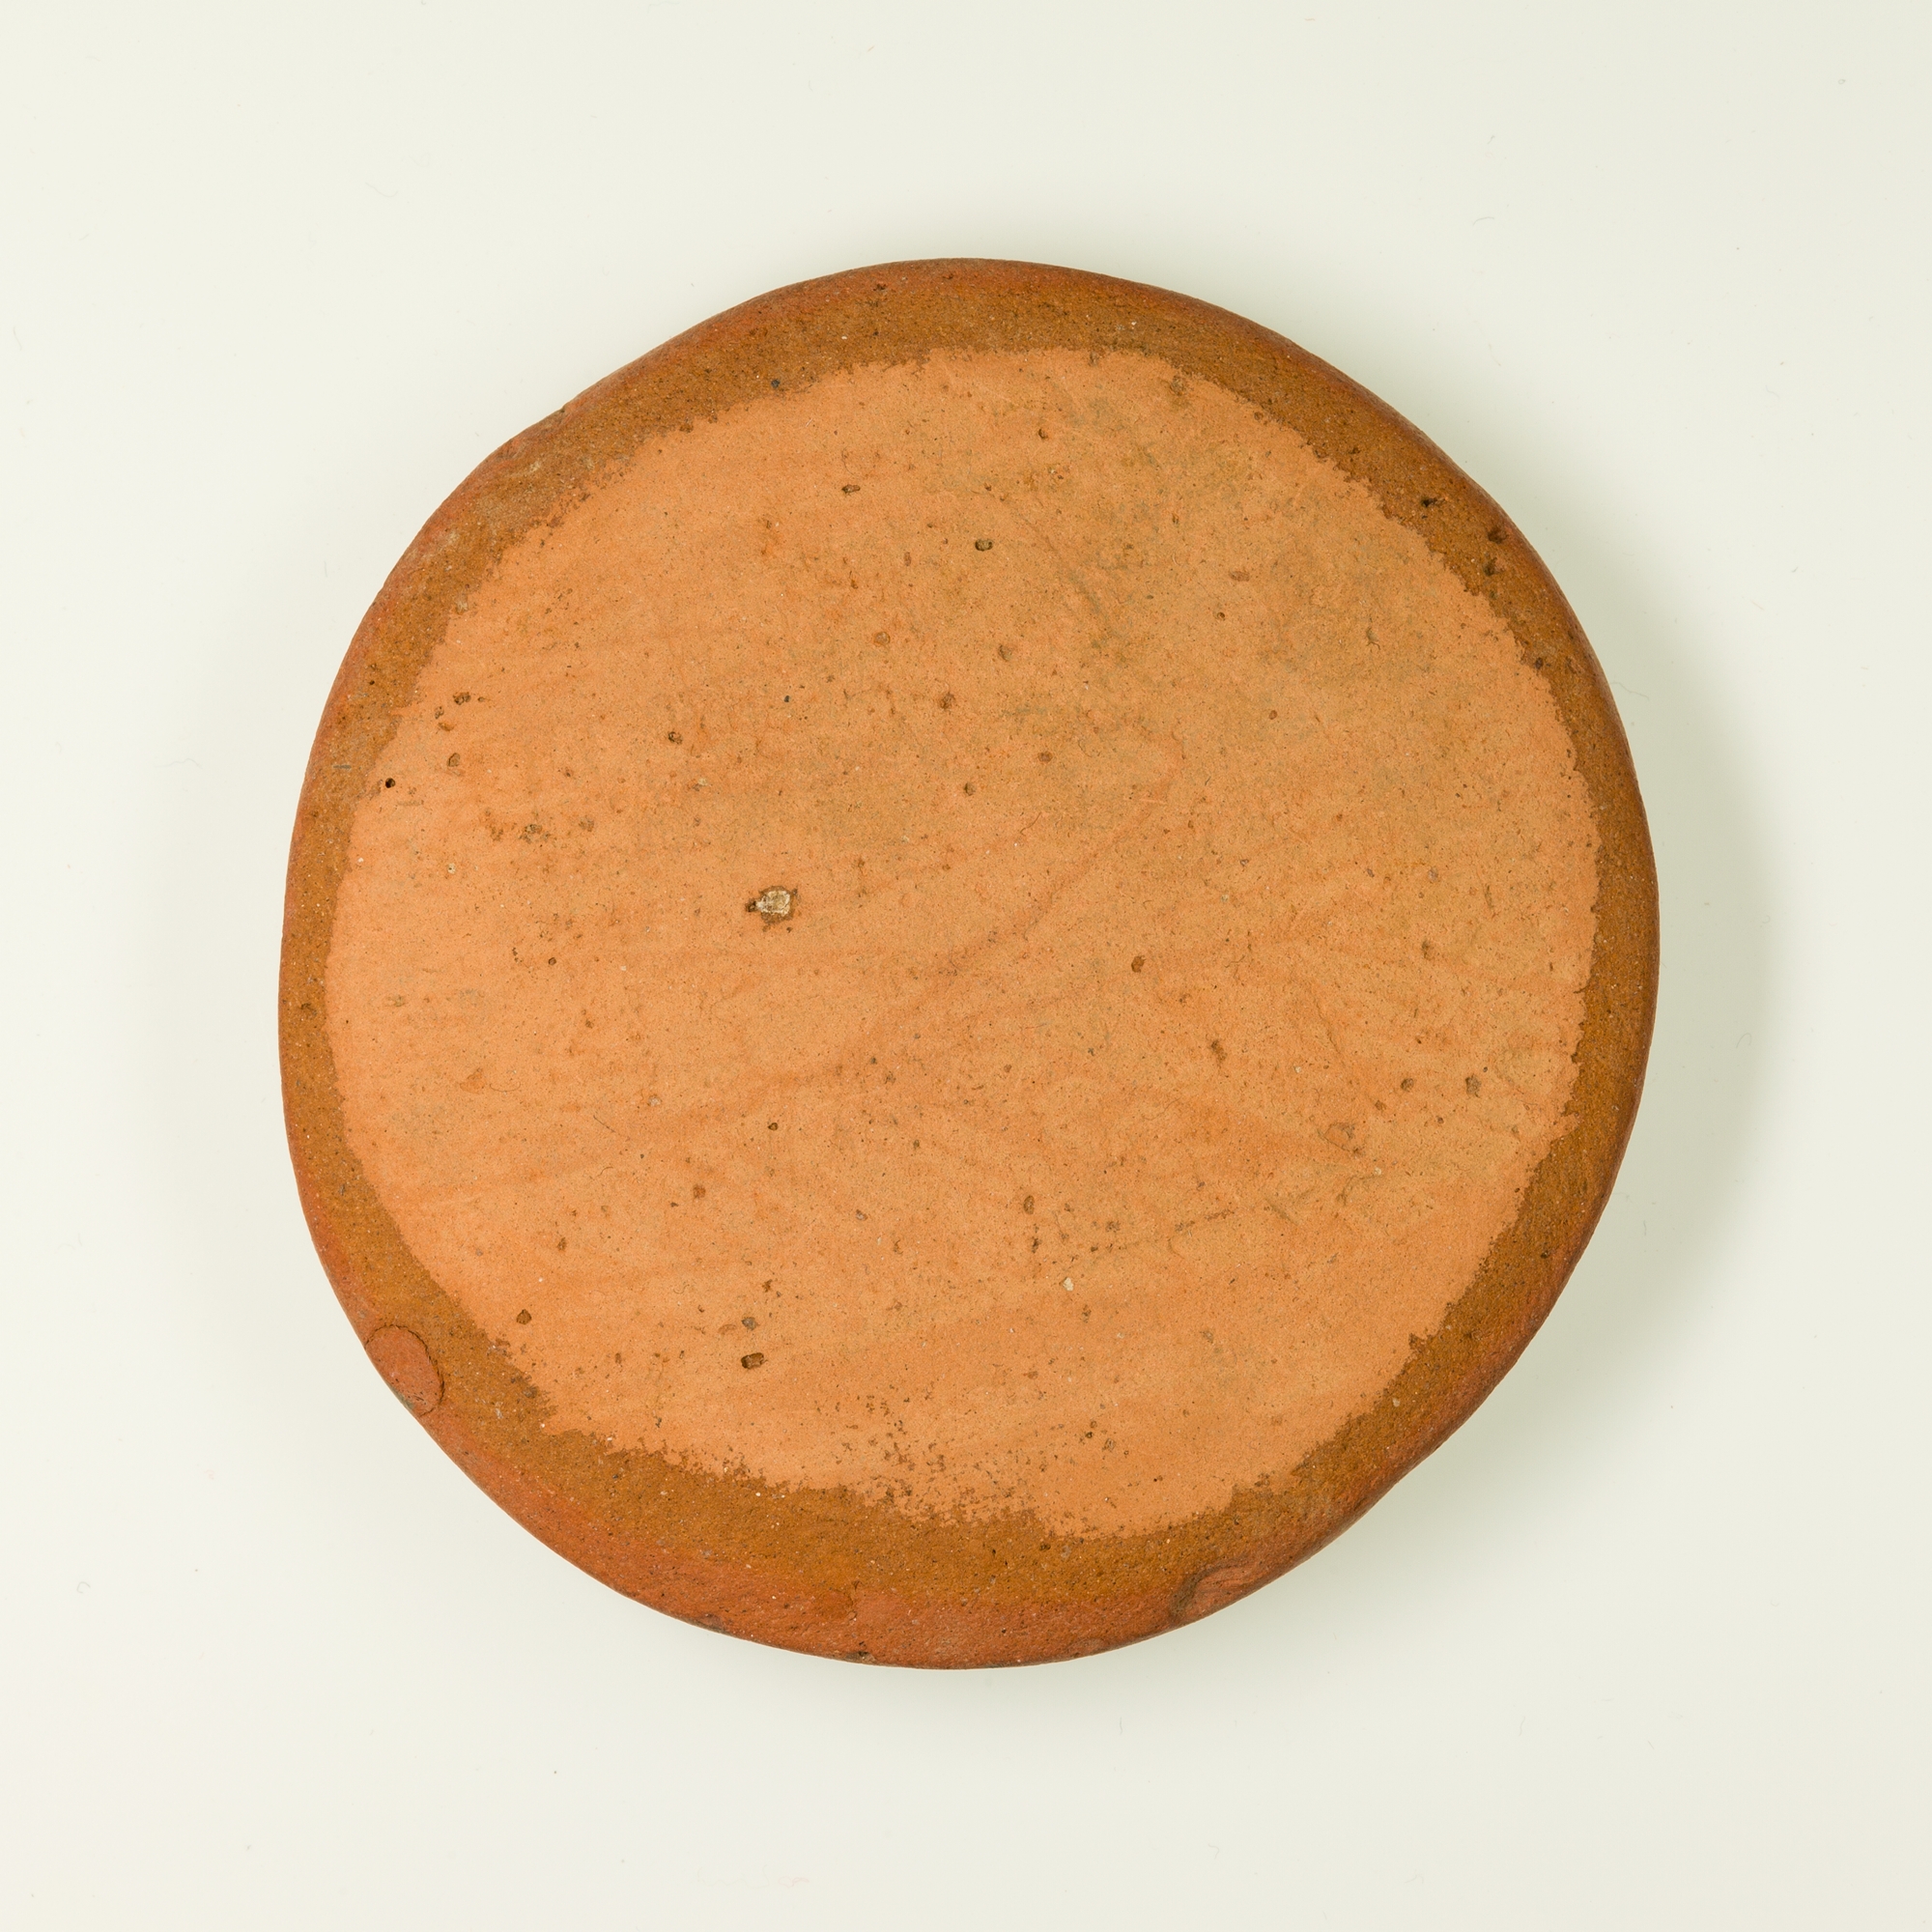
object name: weight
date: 1295-1070 BCE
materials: pottery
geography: egypt